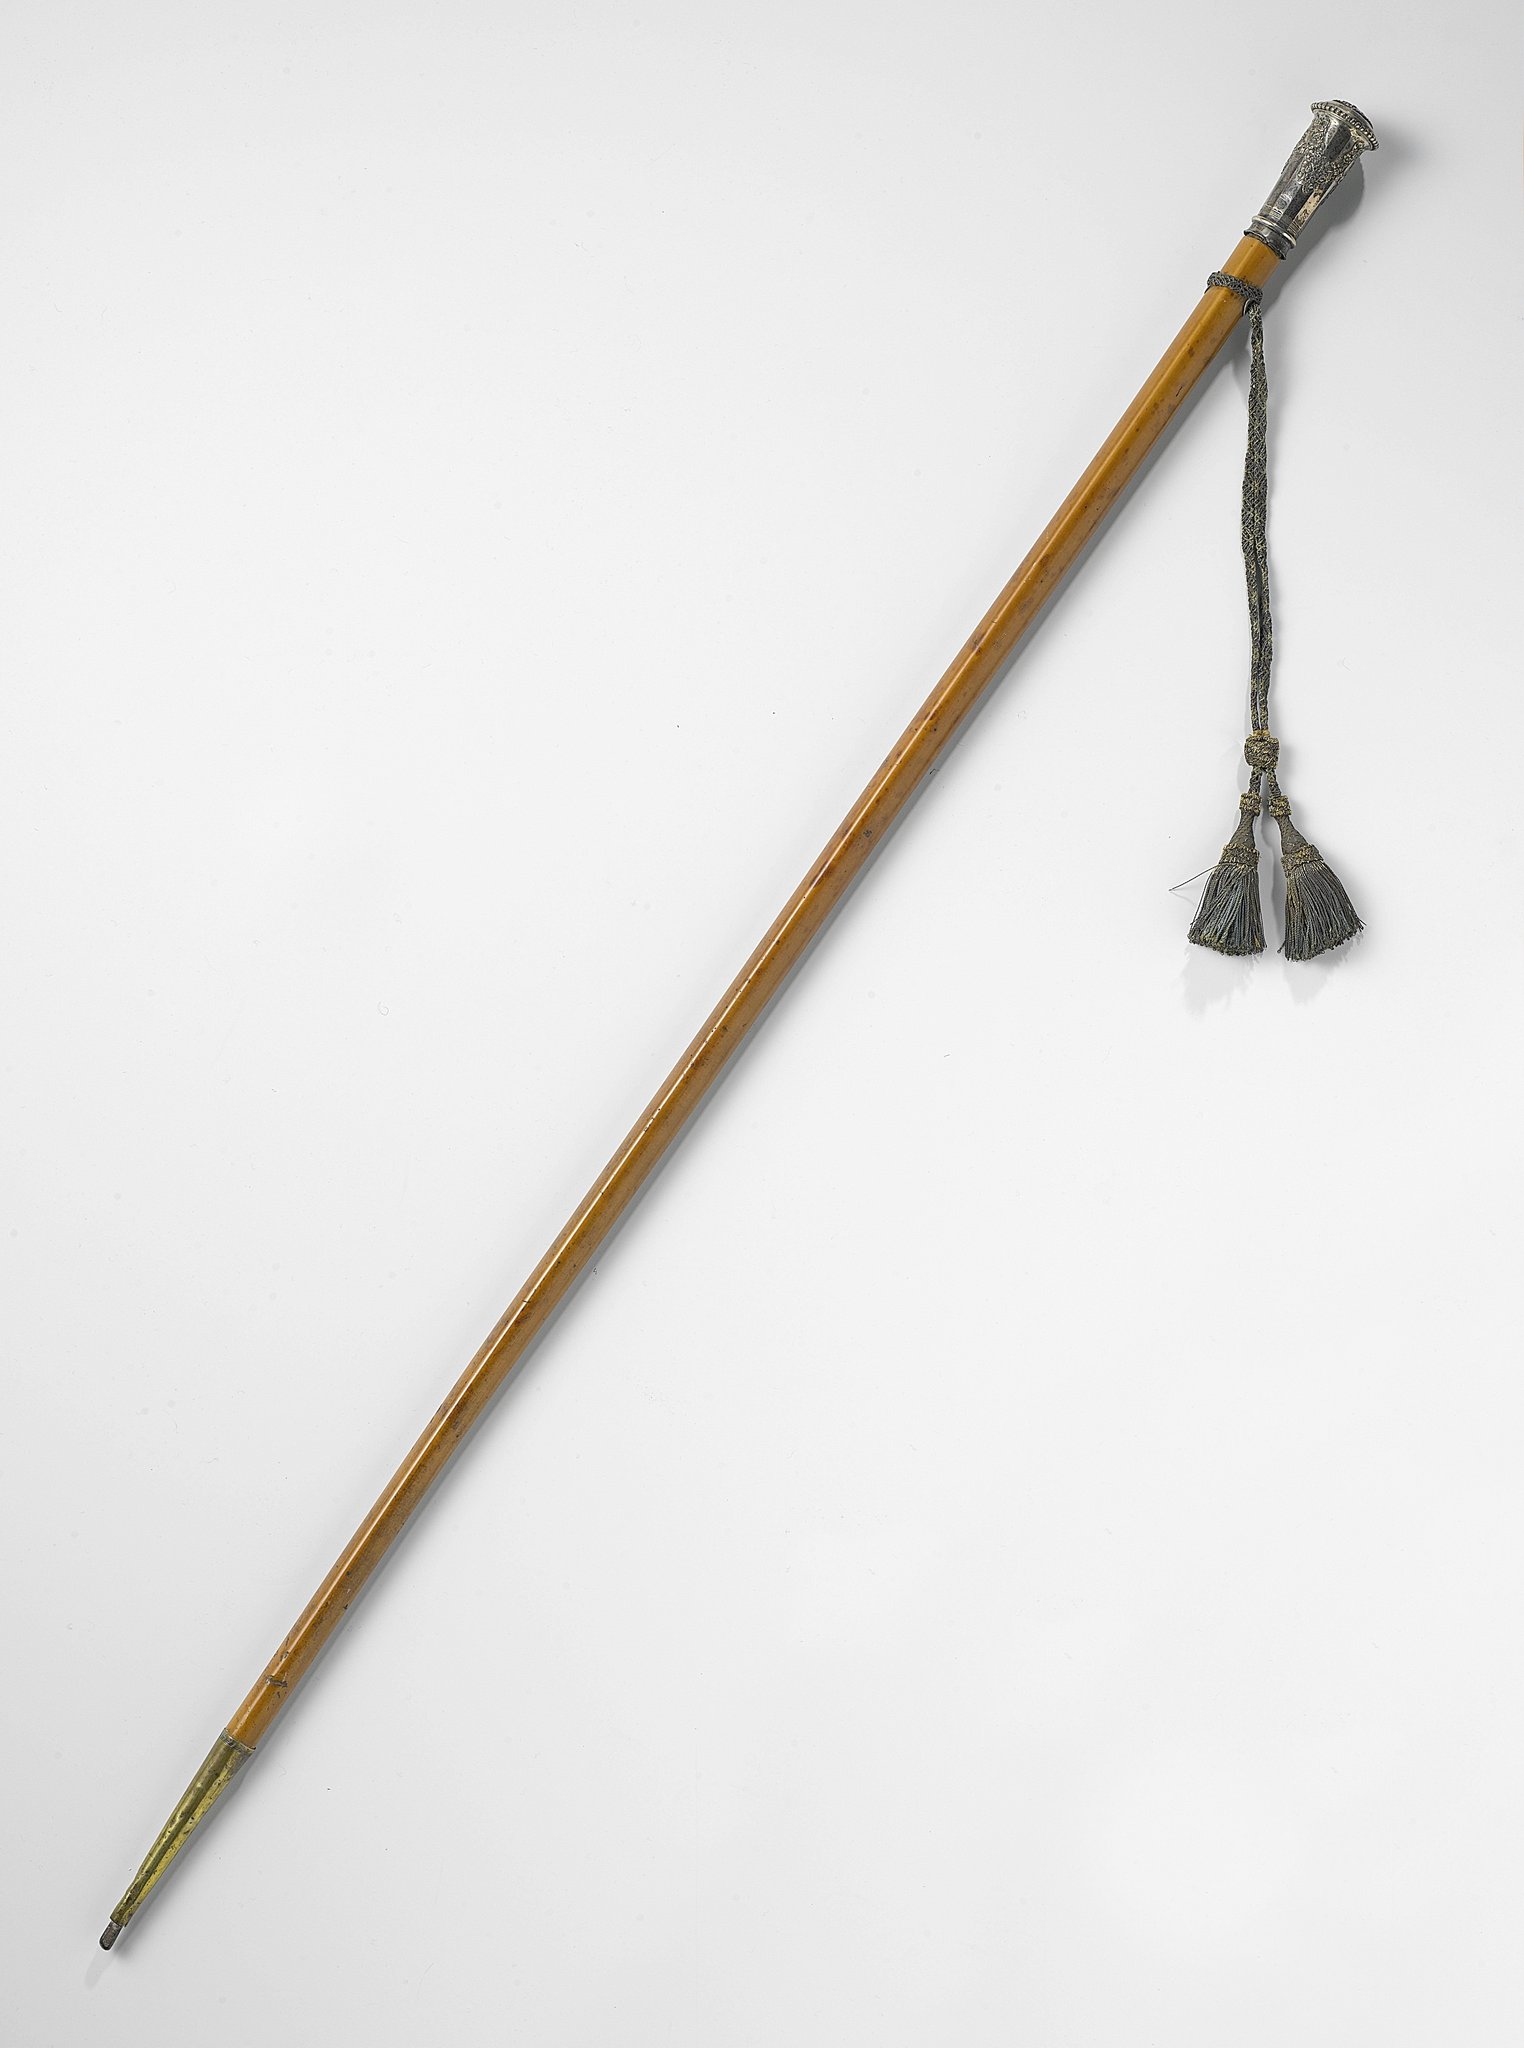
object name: walking stick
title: Wandelstok van bamboe met twaalfzijdige zilveren knop met op bovenzijde de H. Christoffel met Kind Jezus op de arm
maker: Anonymous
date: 1775-1800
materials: copper, metal, rattan, silver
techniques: cutting, forging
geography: europe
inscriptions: mark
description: Rottan wandelstok met zilveren knop. De zilveren knop is twaalfzijdig, voorzien van drie bloemfestoenen verbonden door strikken, terwijl op het bovenvlak met reliëf voorstellende een heilige met het Christuskind gedreven is. De punt van den stok is van koper. Een gevlochten metalen koord met twee kwasten, is bevestigd onder den knop. Merken op den knop: 13 en lopende leeuw.